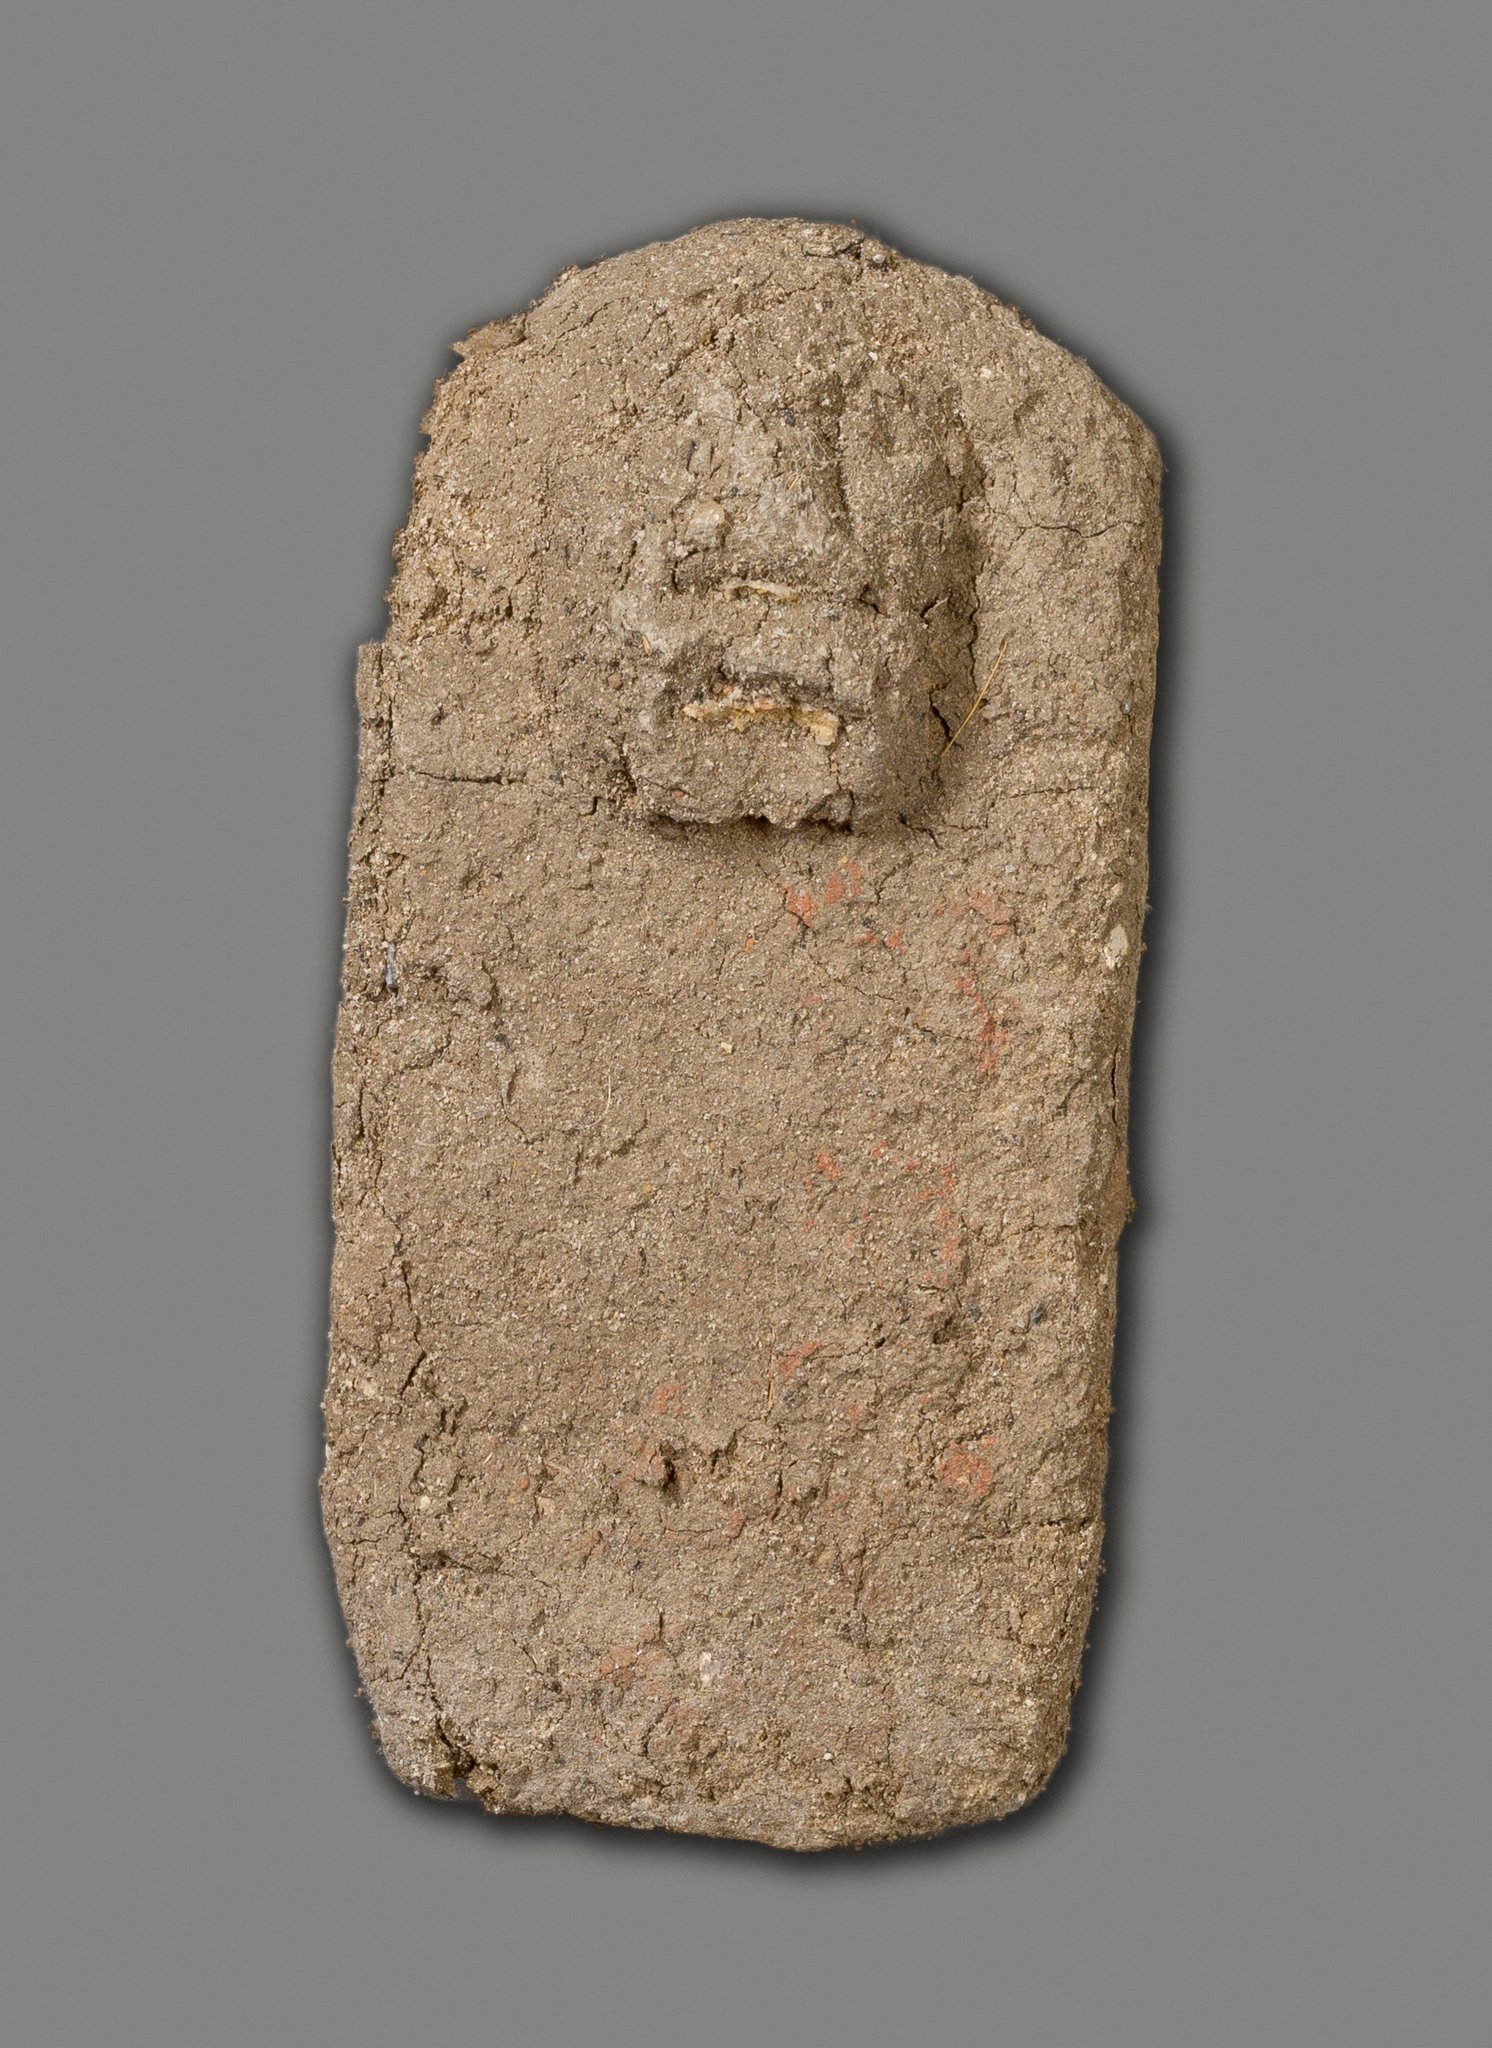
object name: figure, magical, execration, tablet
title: Magical Figure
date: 1802-1550 BCE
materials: clay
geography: egypt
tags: faces